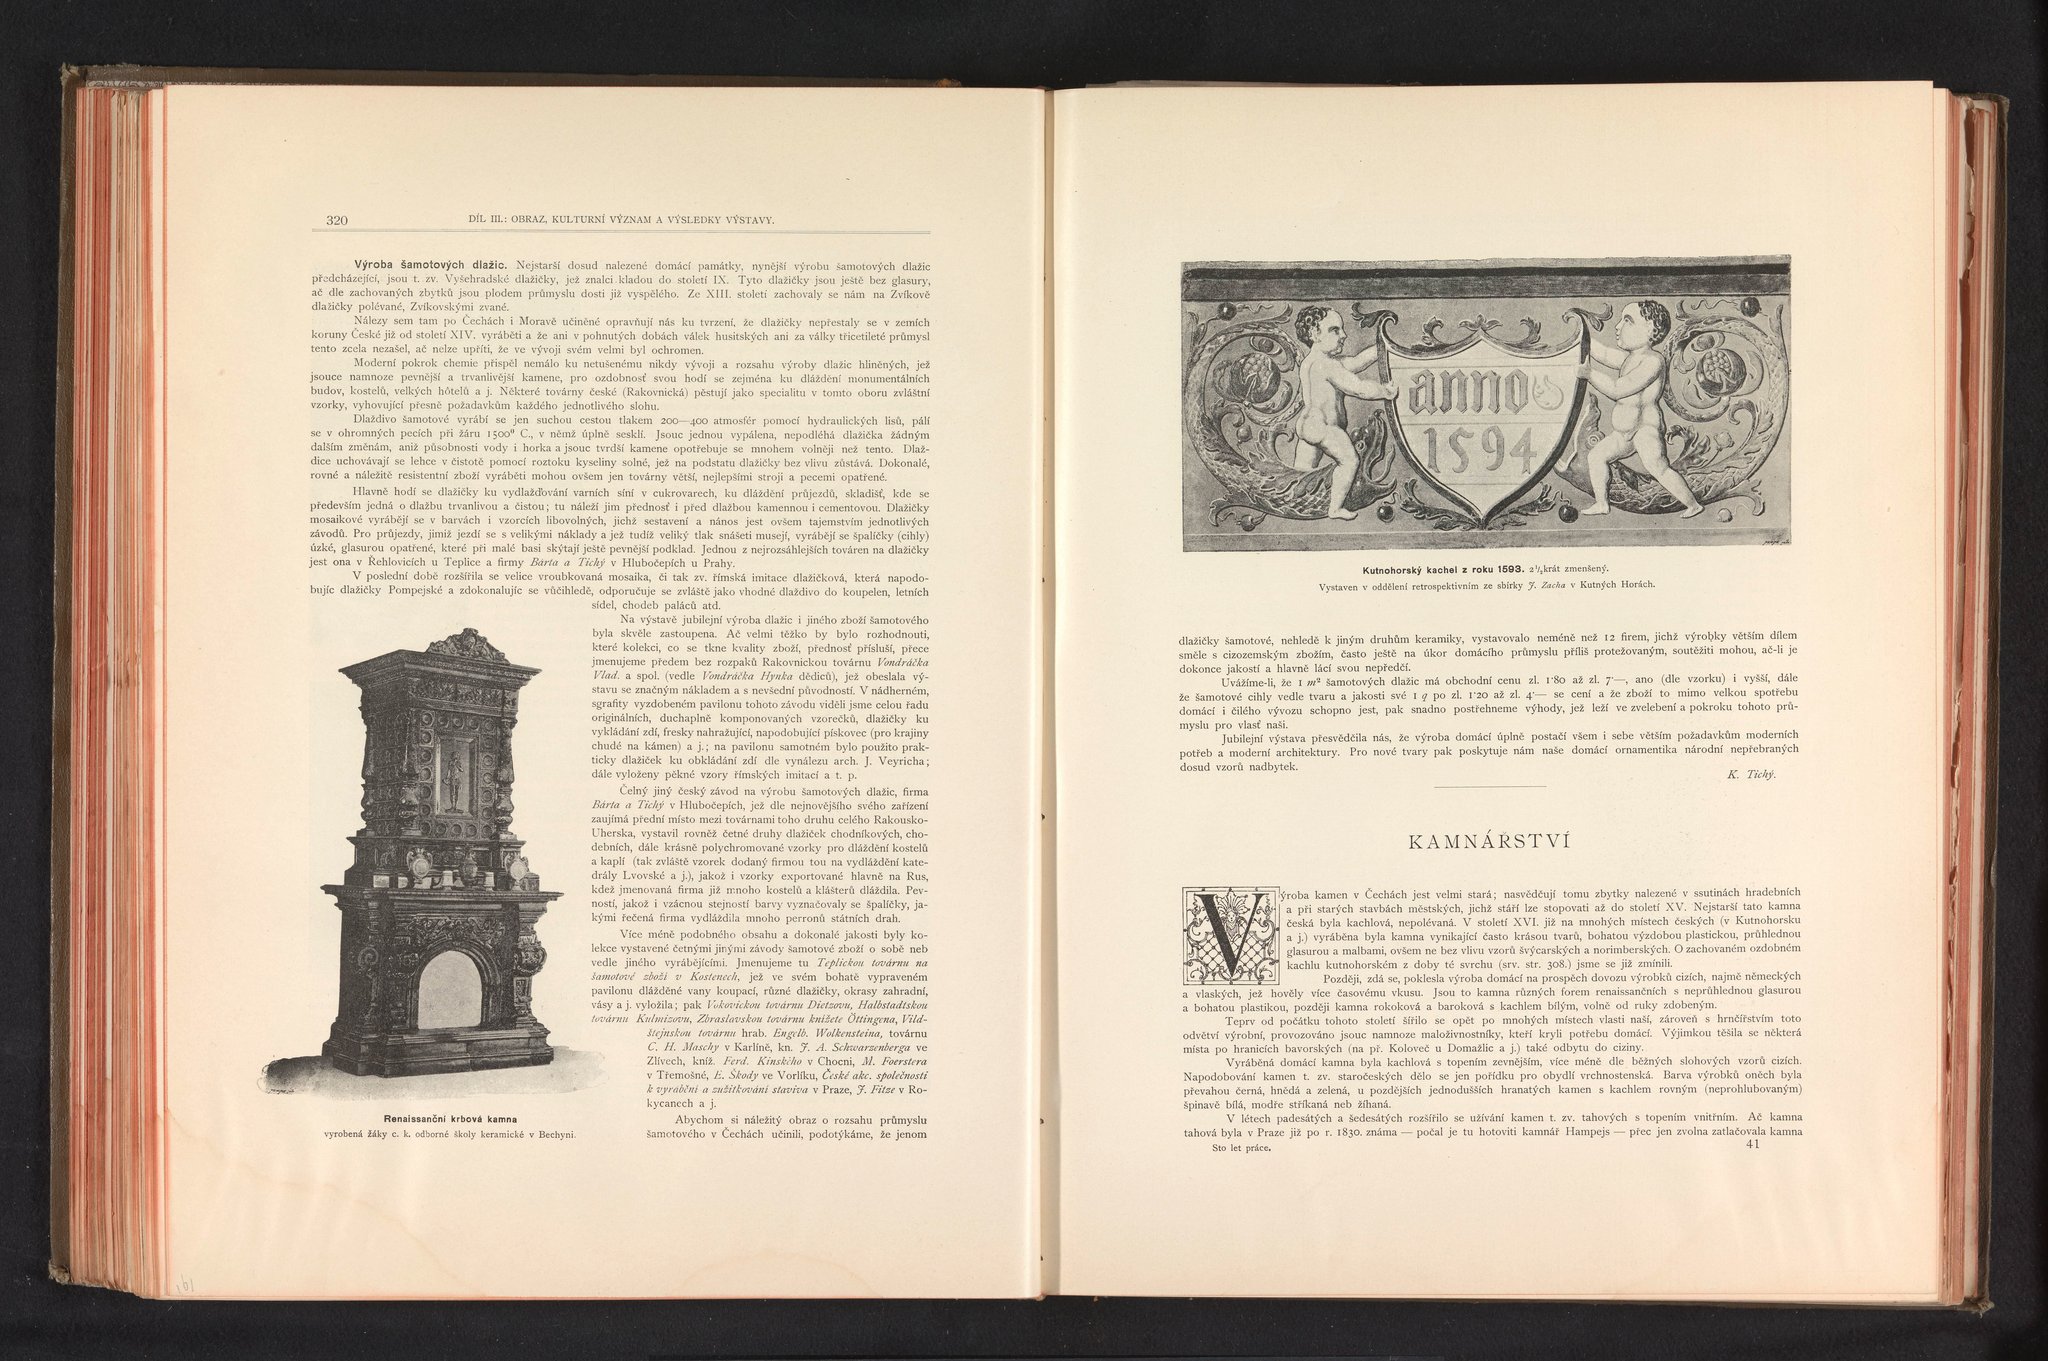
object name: photomechanical print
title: Kutnohorský kachel z roku 1593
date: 1890-1895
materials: paper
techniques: autotype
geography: prague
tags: fabulous animals (sometimes wrongly called 'grotesques'); 'mostri' (ripa), tiles, bricks ~ building material, cupids: 'amores', 'amoretti', 'putti'